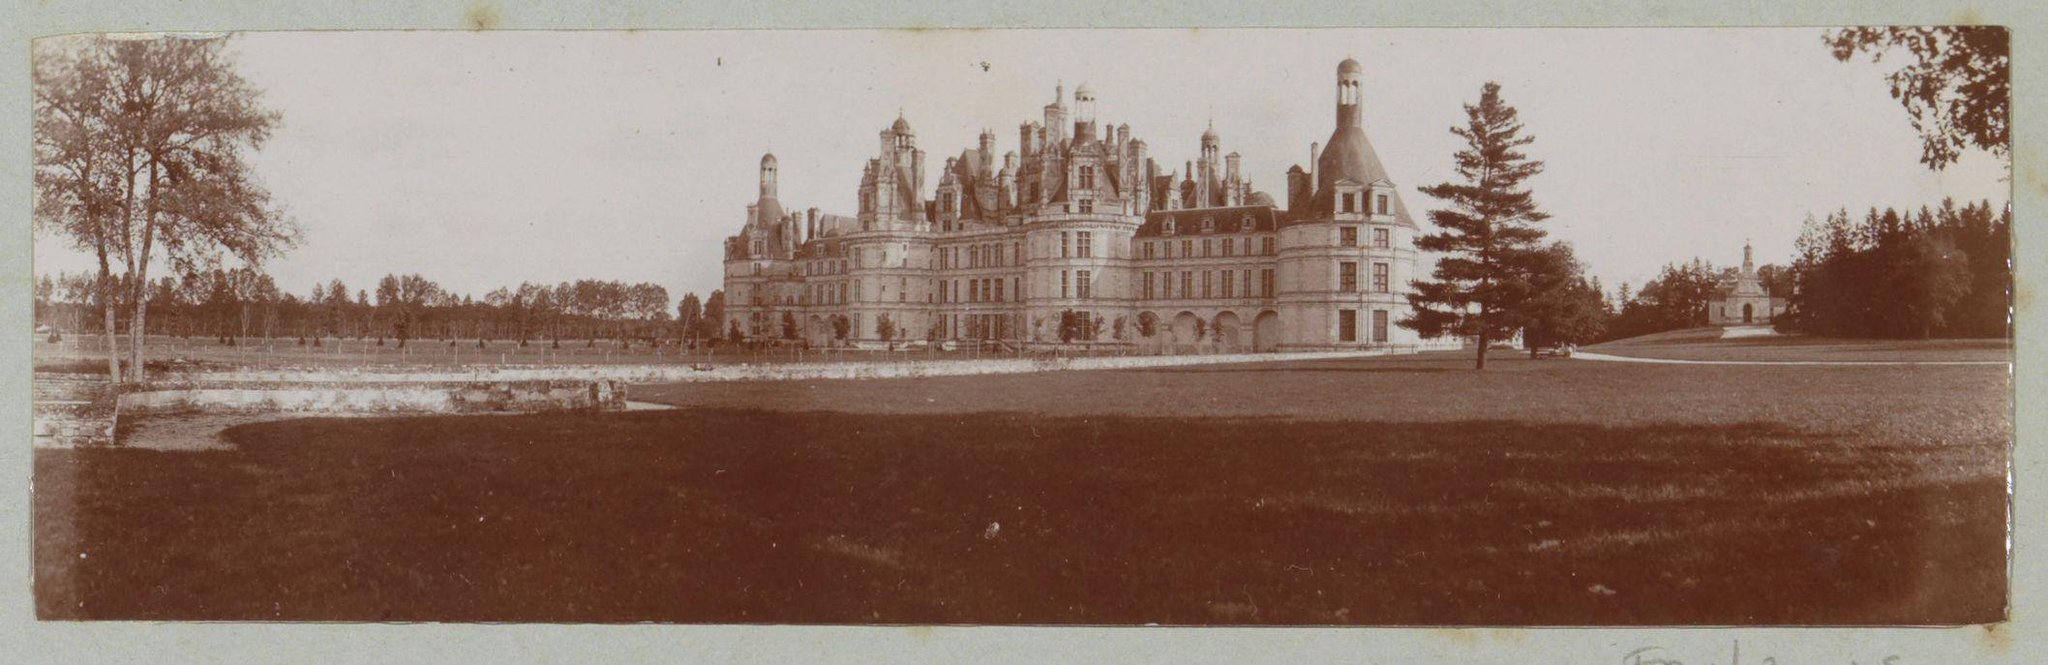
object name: panoramic photograph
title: Gezicht op het kasteel van Chambord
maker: delizy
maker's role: manufacturer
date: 1904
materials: paper, photographic support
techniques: gelatin silver print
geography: chambord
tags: castle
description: Onderdeel van Fotoalbum van een Franse amateurfotograaf met opnames van uitstapjes in Frankrijk, Spanje, België, Luxemburg en Nederland, de eerste automobielen en autoraces.